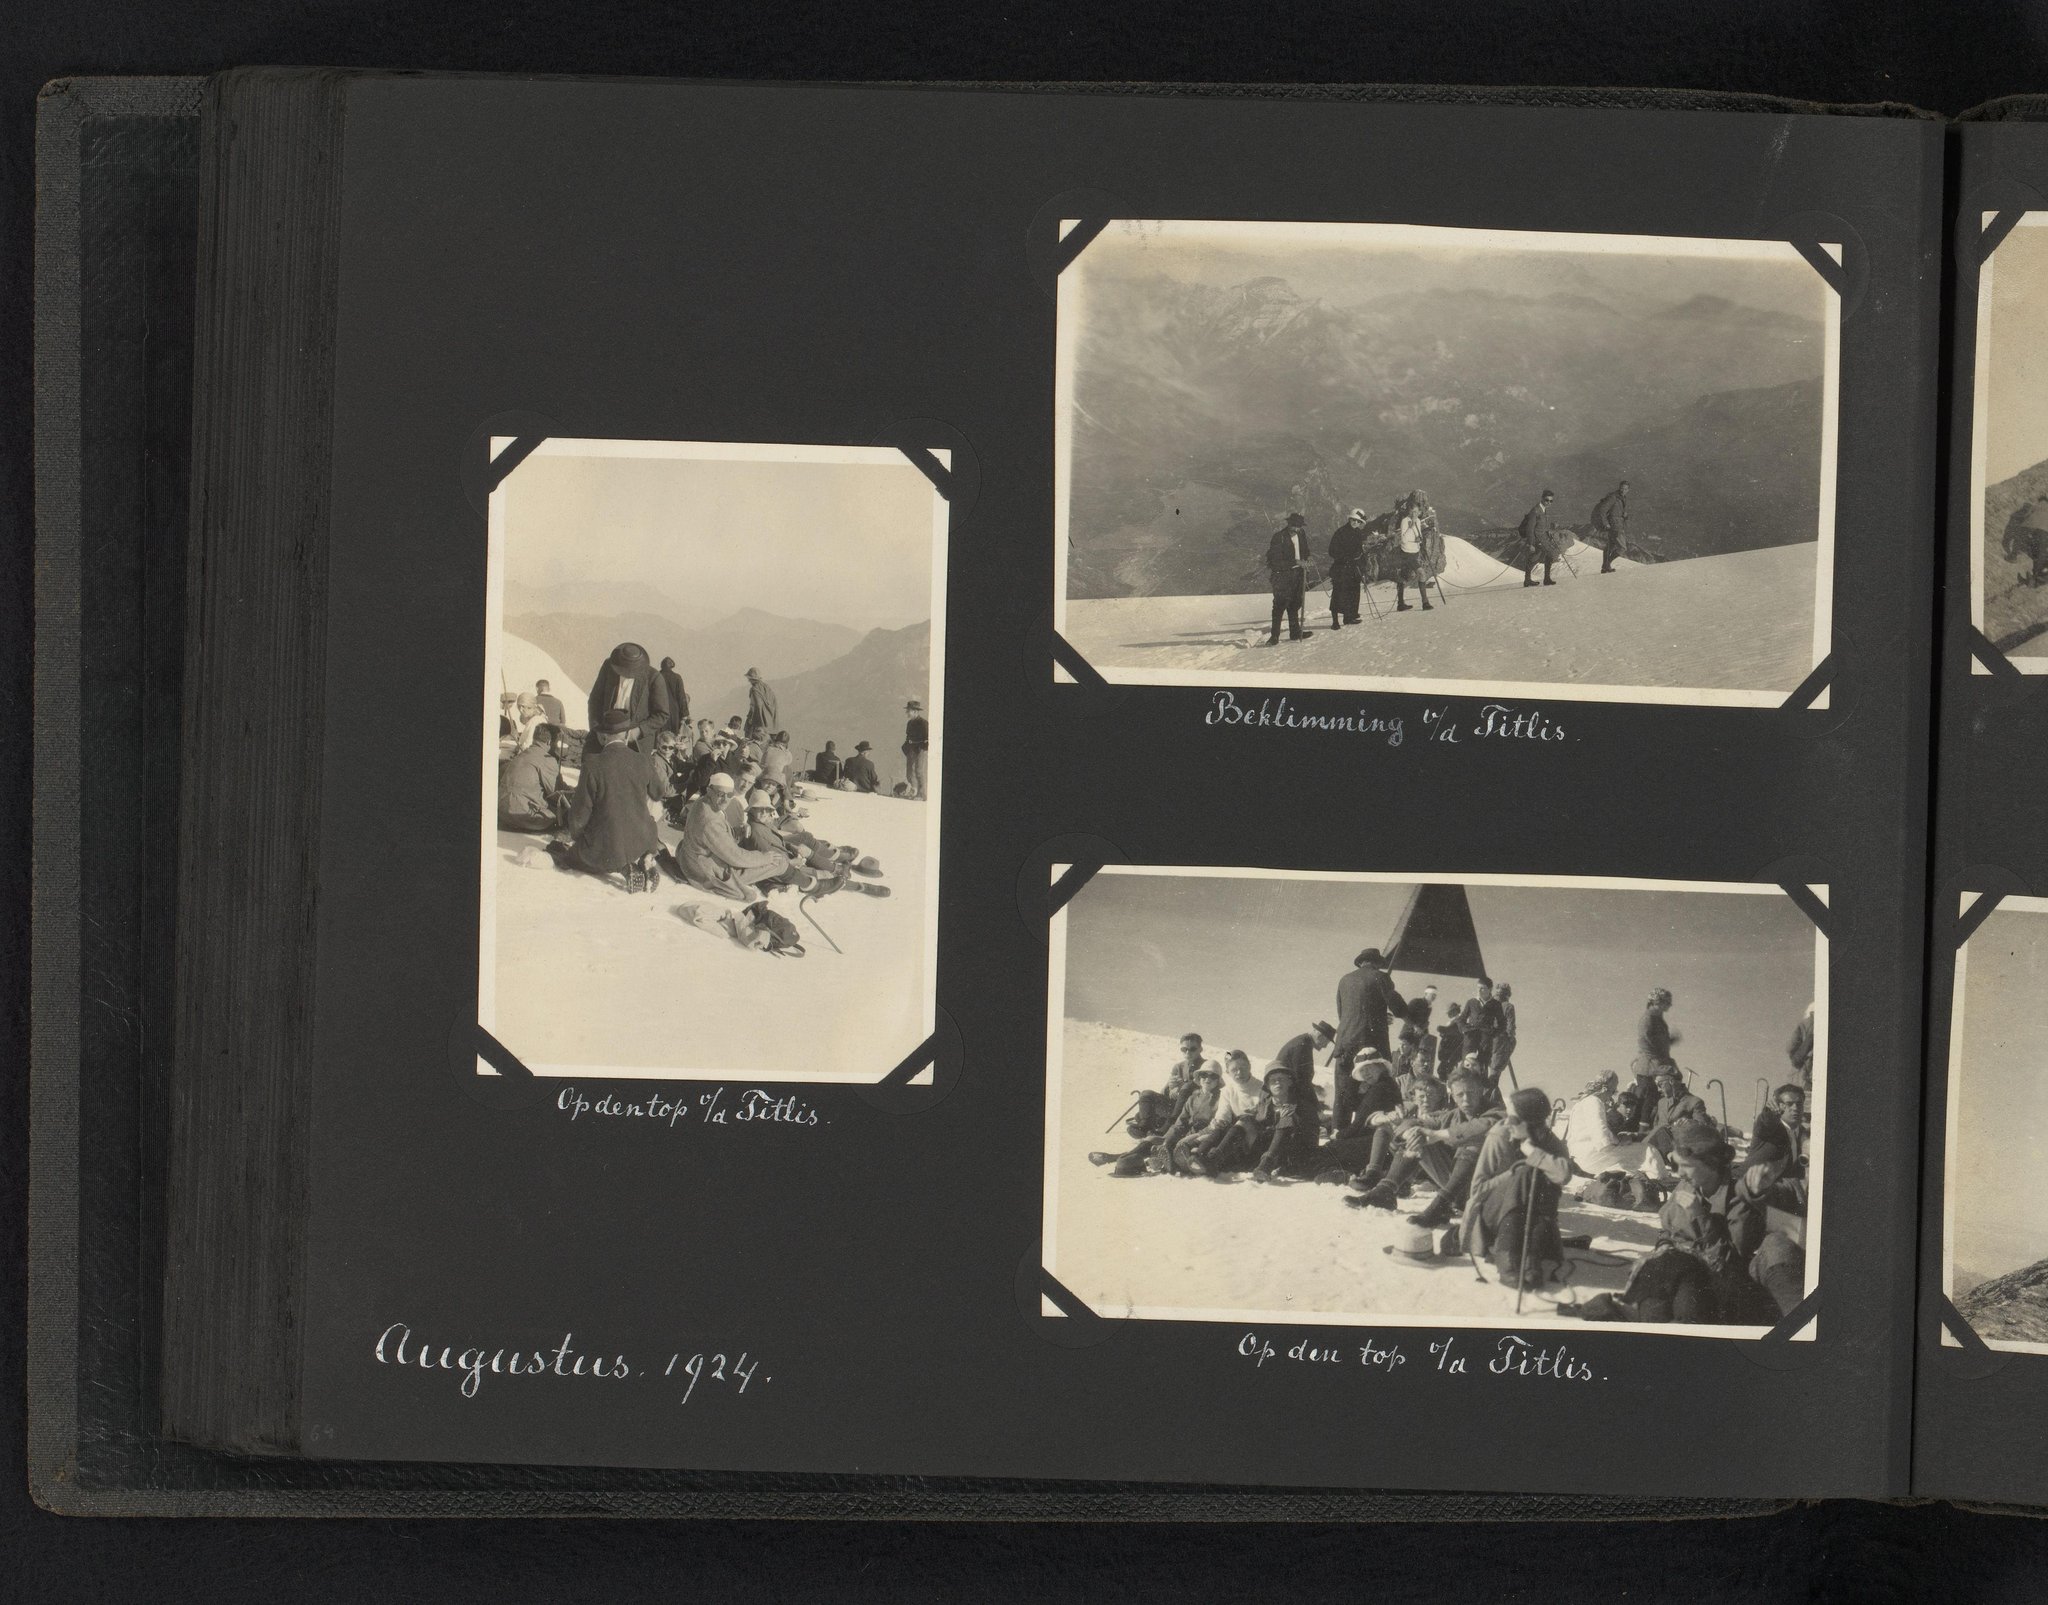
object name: photograph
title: Drie foto's van de beklimming van de Titlis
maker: hendrik herman van den berg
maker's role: amateurfotograaf, jurist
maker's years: 1875-1944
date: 1908-1924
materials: paper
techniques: gelatin silver print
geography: titlis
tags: walking, hiking (recreation), mountains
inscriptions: inscription: ‘Op den top v/d Titlis’, inscription: ‘Beklimming v/d Titlis’, inscription: ‘Op den top v/d Titlis’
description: Deze foto's maken deel uit van een album.